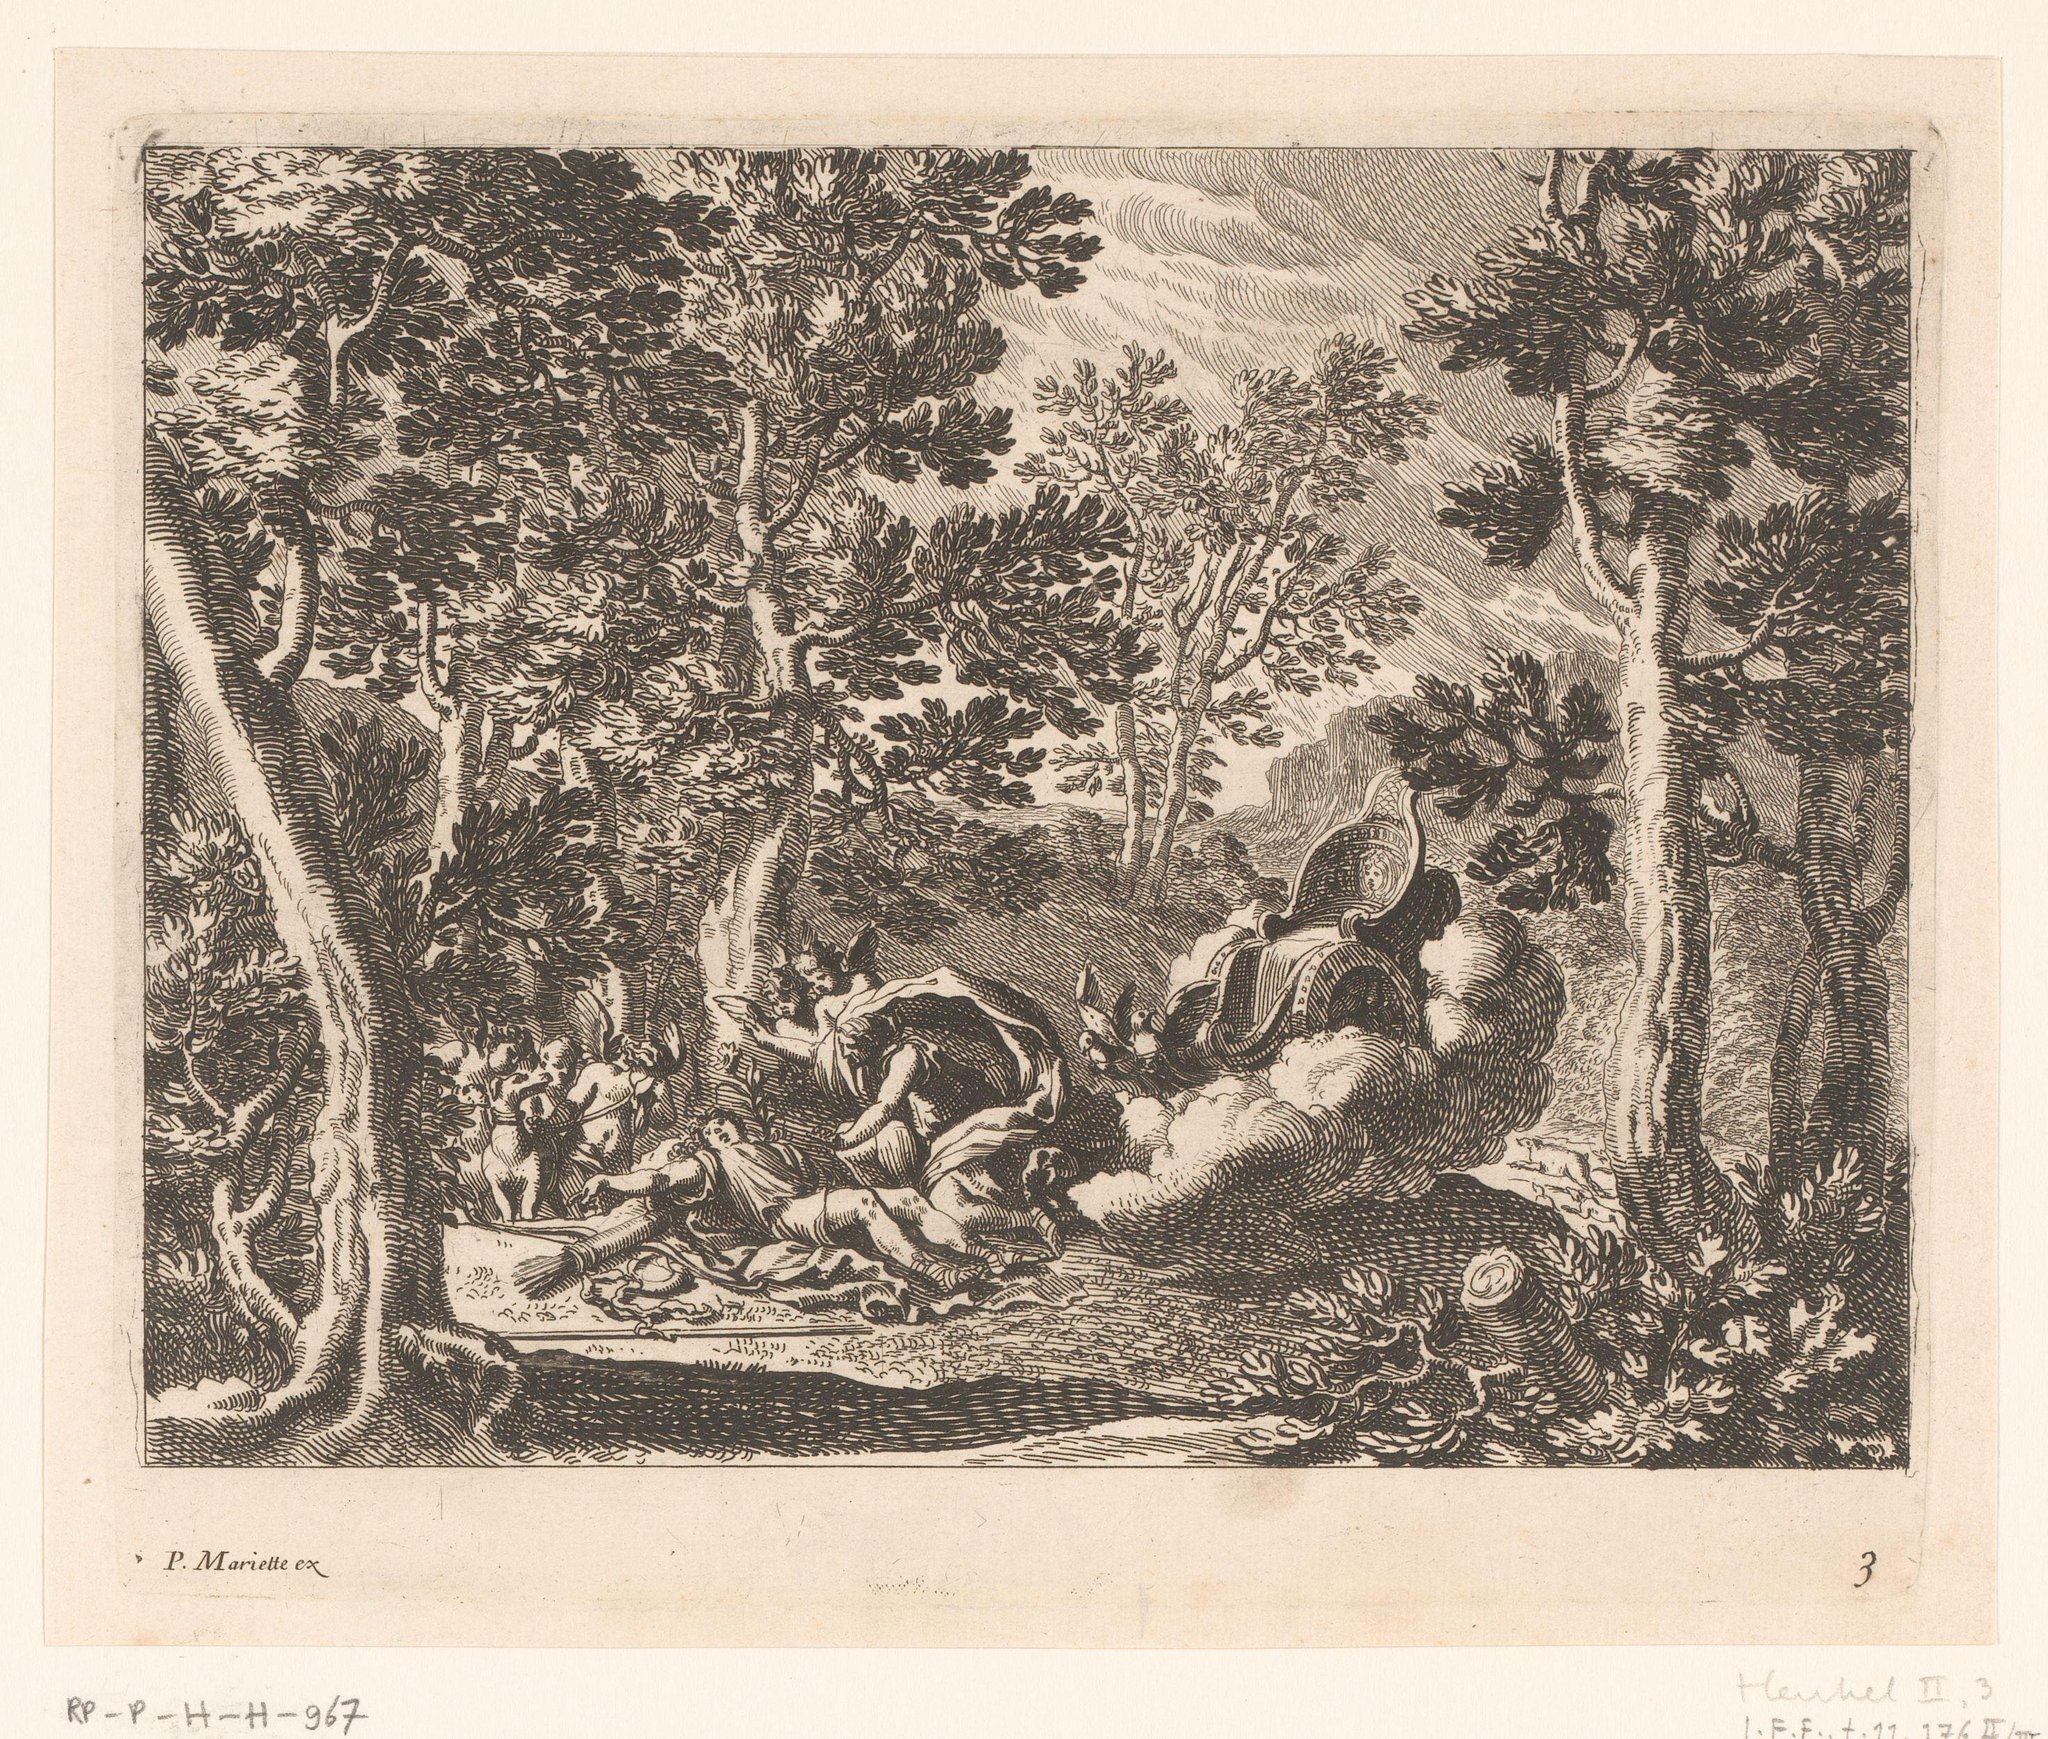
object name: print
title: Mythologische scènes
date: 1628-1682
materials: paper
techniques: etching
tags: venus mourning adonis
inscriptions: collector's mark: Lugt 11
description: Maakt deel uit van een twintigdelige serie met mythologische scènes.